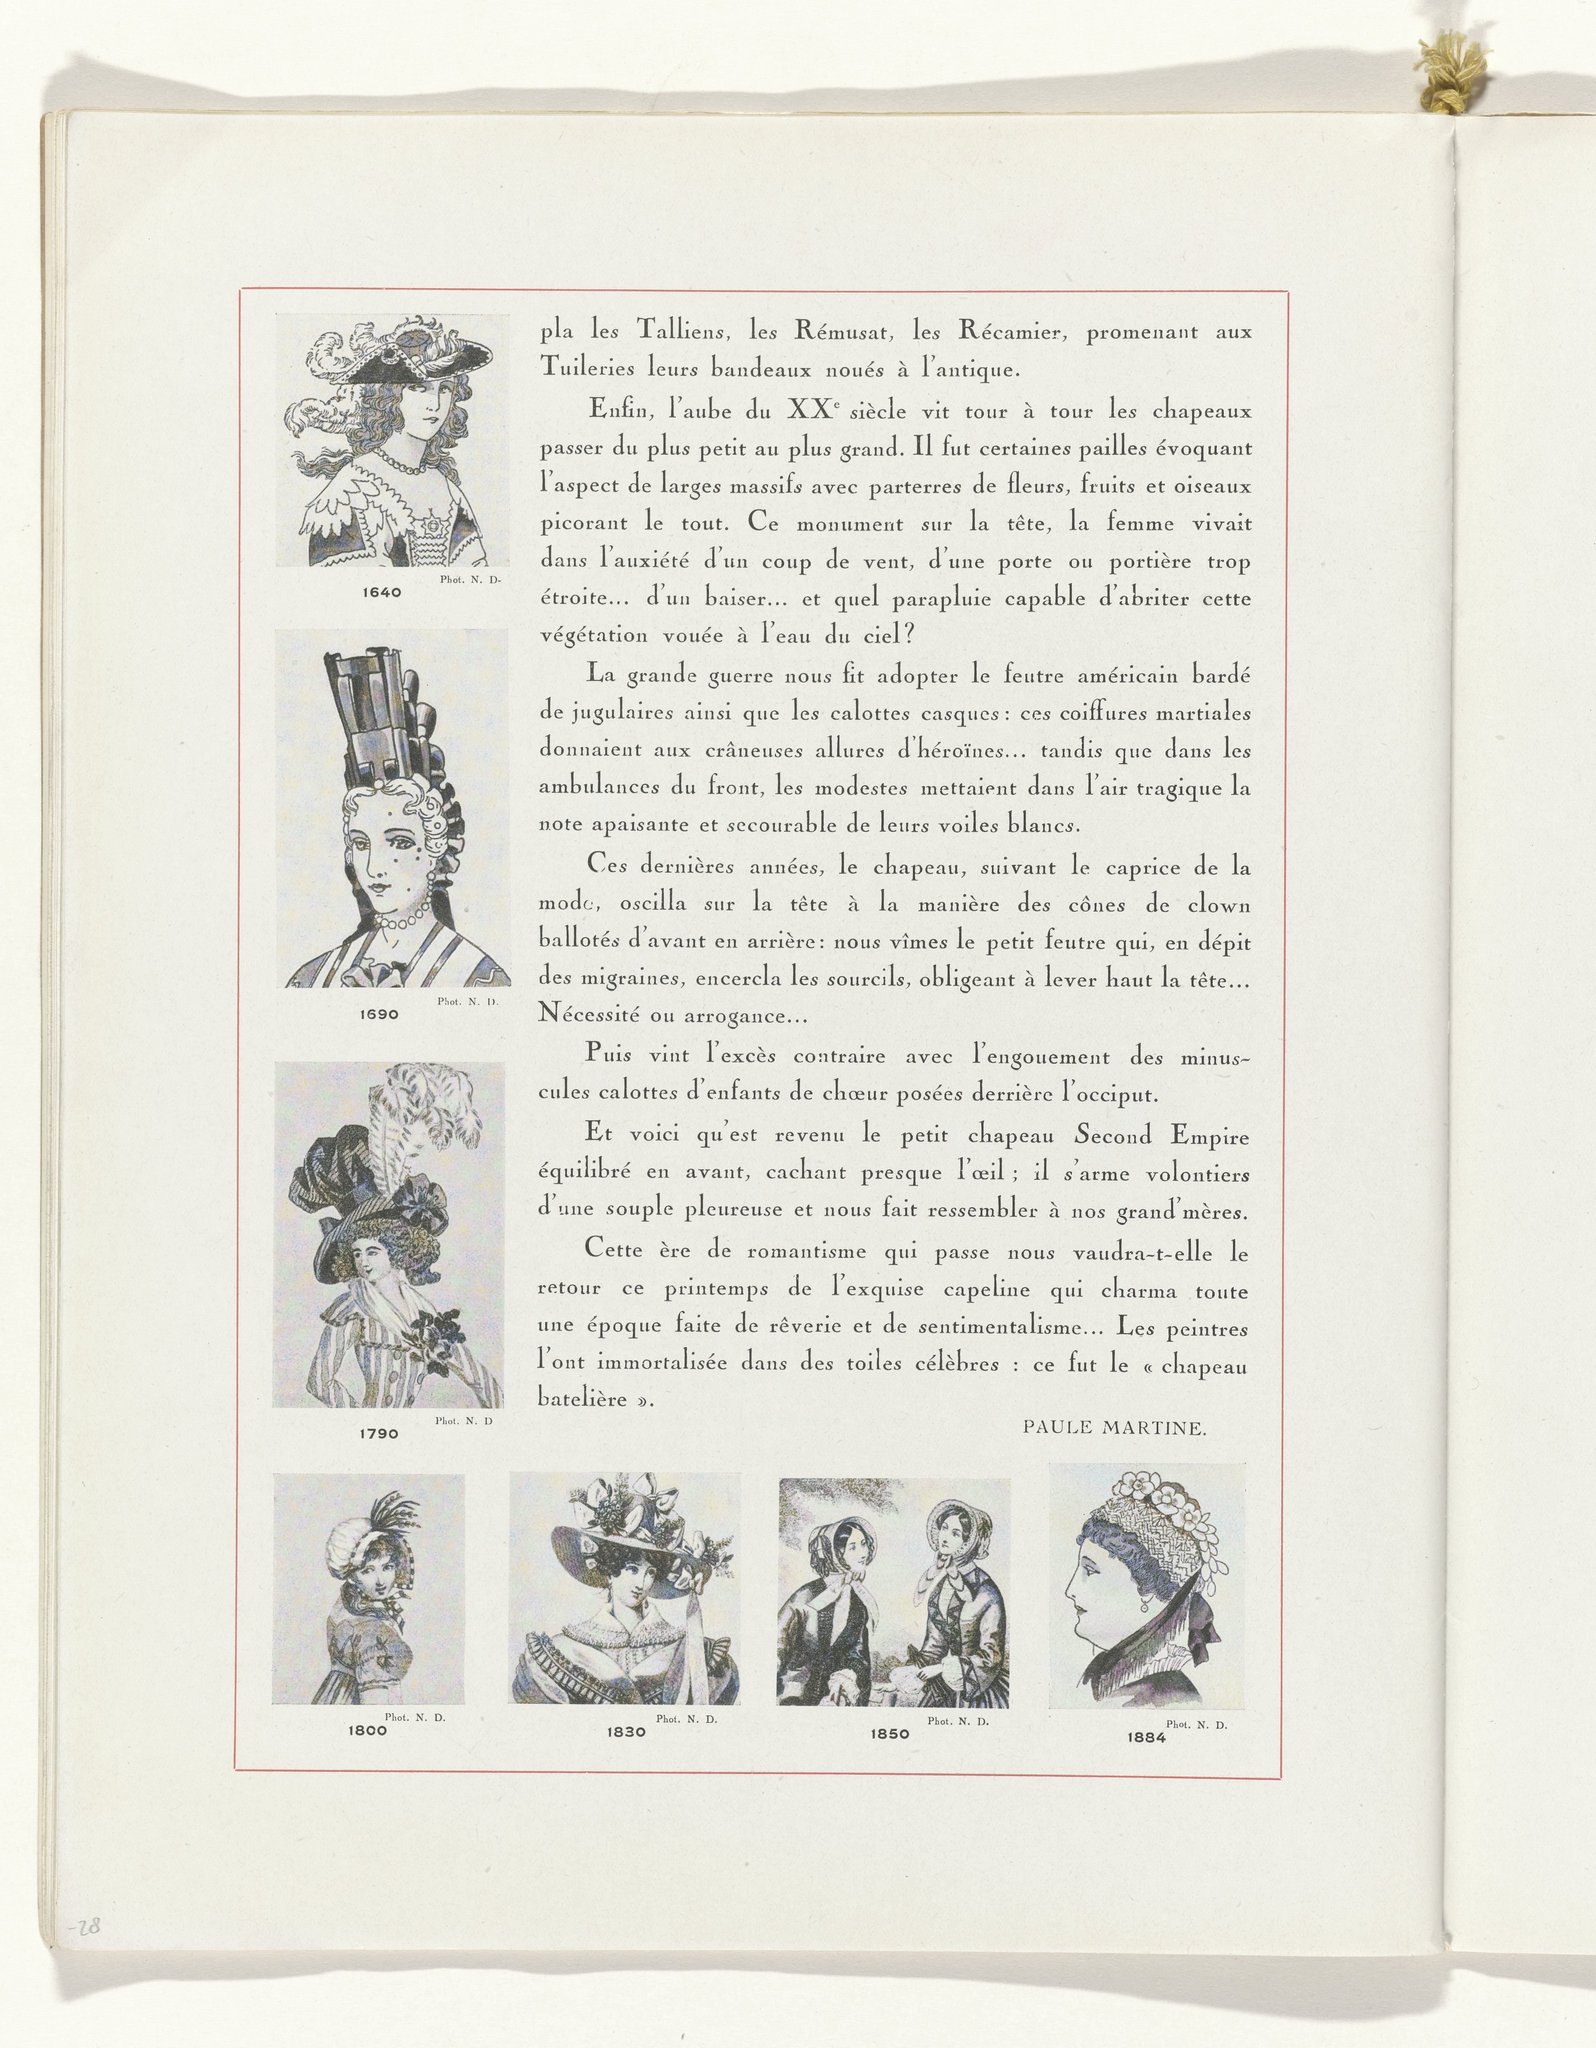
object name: magazine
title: Art - Goût - Beauté, Feuillets de l' élégance féminine, Mars 1932, No. 139, 12e Année, p. 28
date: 1932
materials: paper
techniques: printing, photography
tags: styles of hairdress - aa - ~ women, fashion plates, head-gear: hat (+ women's clothes), head-gear: fontange (+ women's clothes)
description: Vervolg van de tekst 'La coiffure à travers les Ages' met zeven afbeeldingen van kapsels uit 1640, 1690, 1790, 1800, 1830, 1850 en 1884. Pagina uit het modetijdschrift Art-Goût-Beauté (1920-1933).